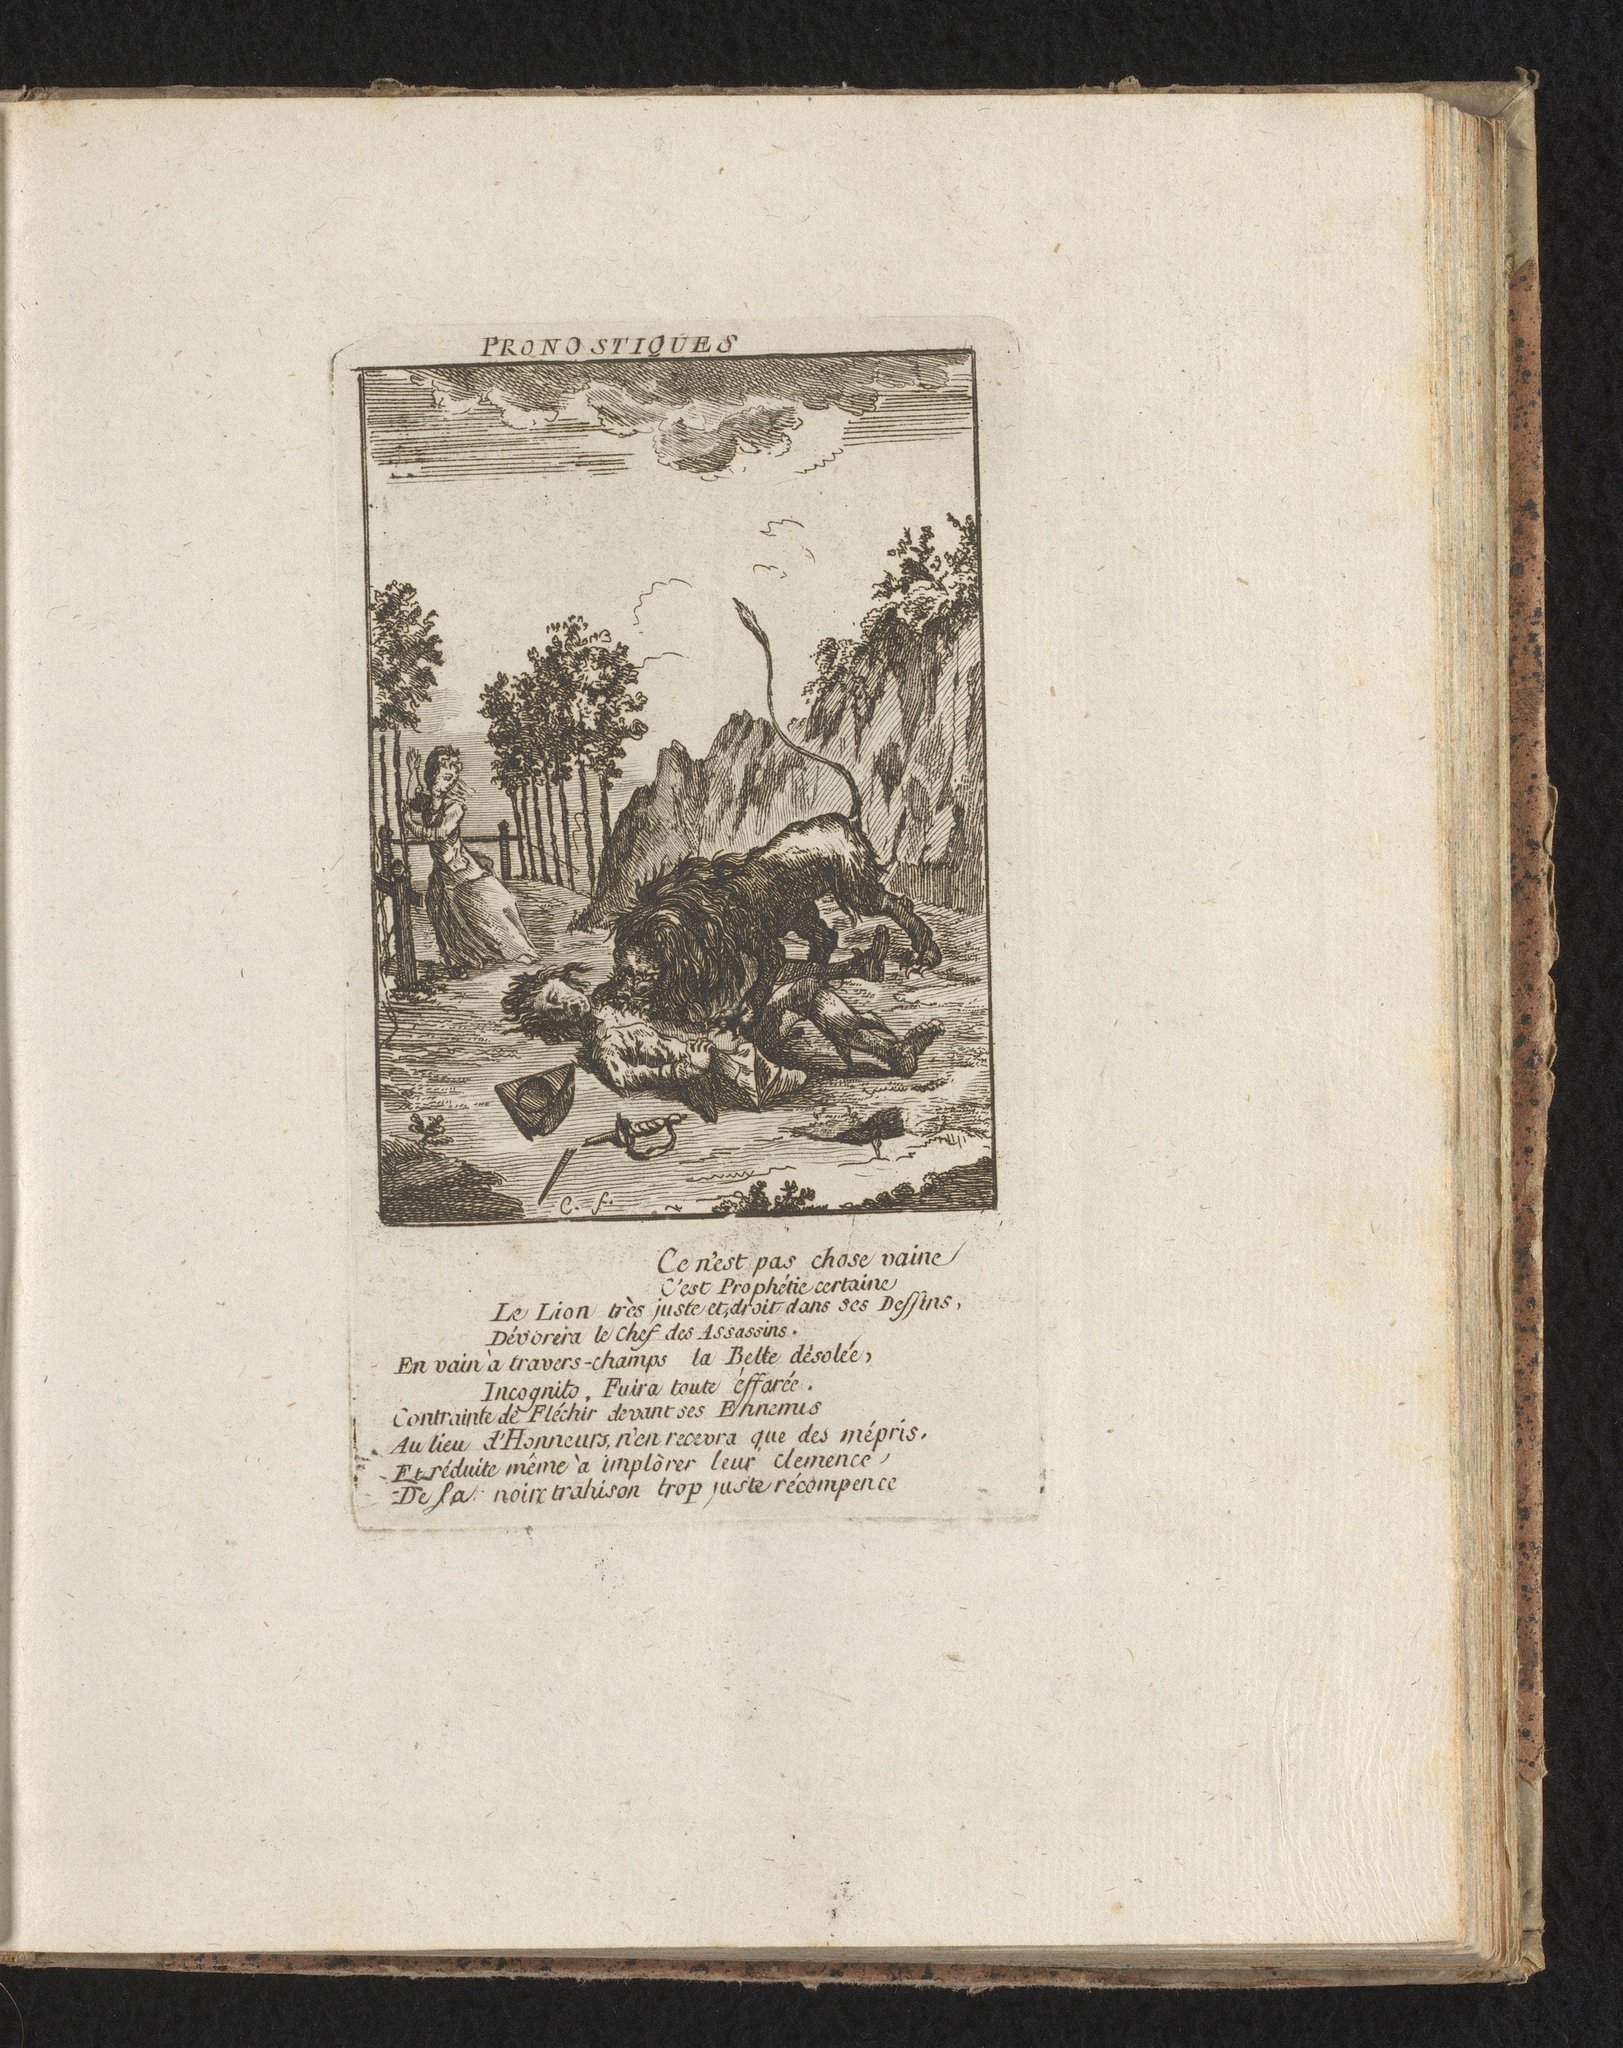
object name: cartoon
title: Leider van de moordenaars verscheurd door de Brabantse leeuw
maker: Anonymous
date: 1787-1790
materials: paper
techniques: engraving, etching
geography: southern netherlands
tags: (corpse of) man eaten by animals, brabant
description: Spotprent waarin de leider van de moordenaars (d'Alton of Trauttmansdorff) verscheurd wordt door de Brabantse leeuw. Met onderschrift van 10 regels in het Frans. Onderdeel van de gebundelde verzameling prenten betrekking hebbend op de gebeurtenissen van de Brabantse Omwenteling en de periode 1787-1790.